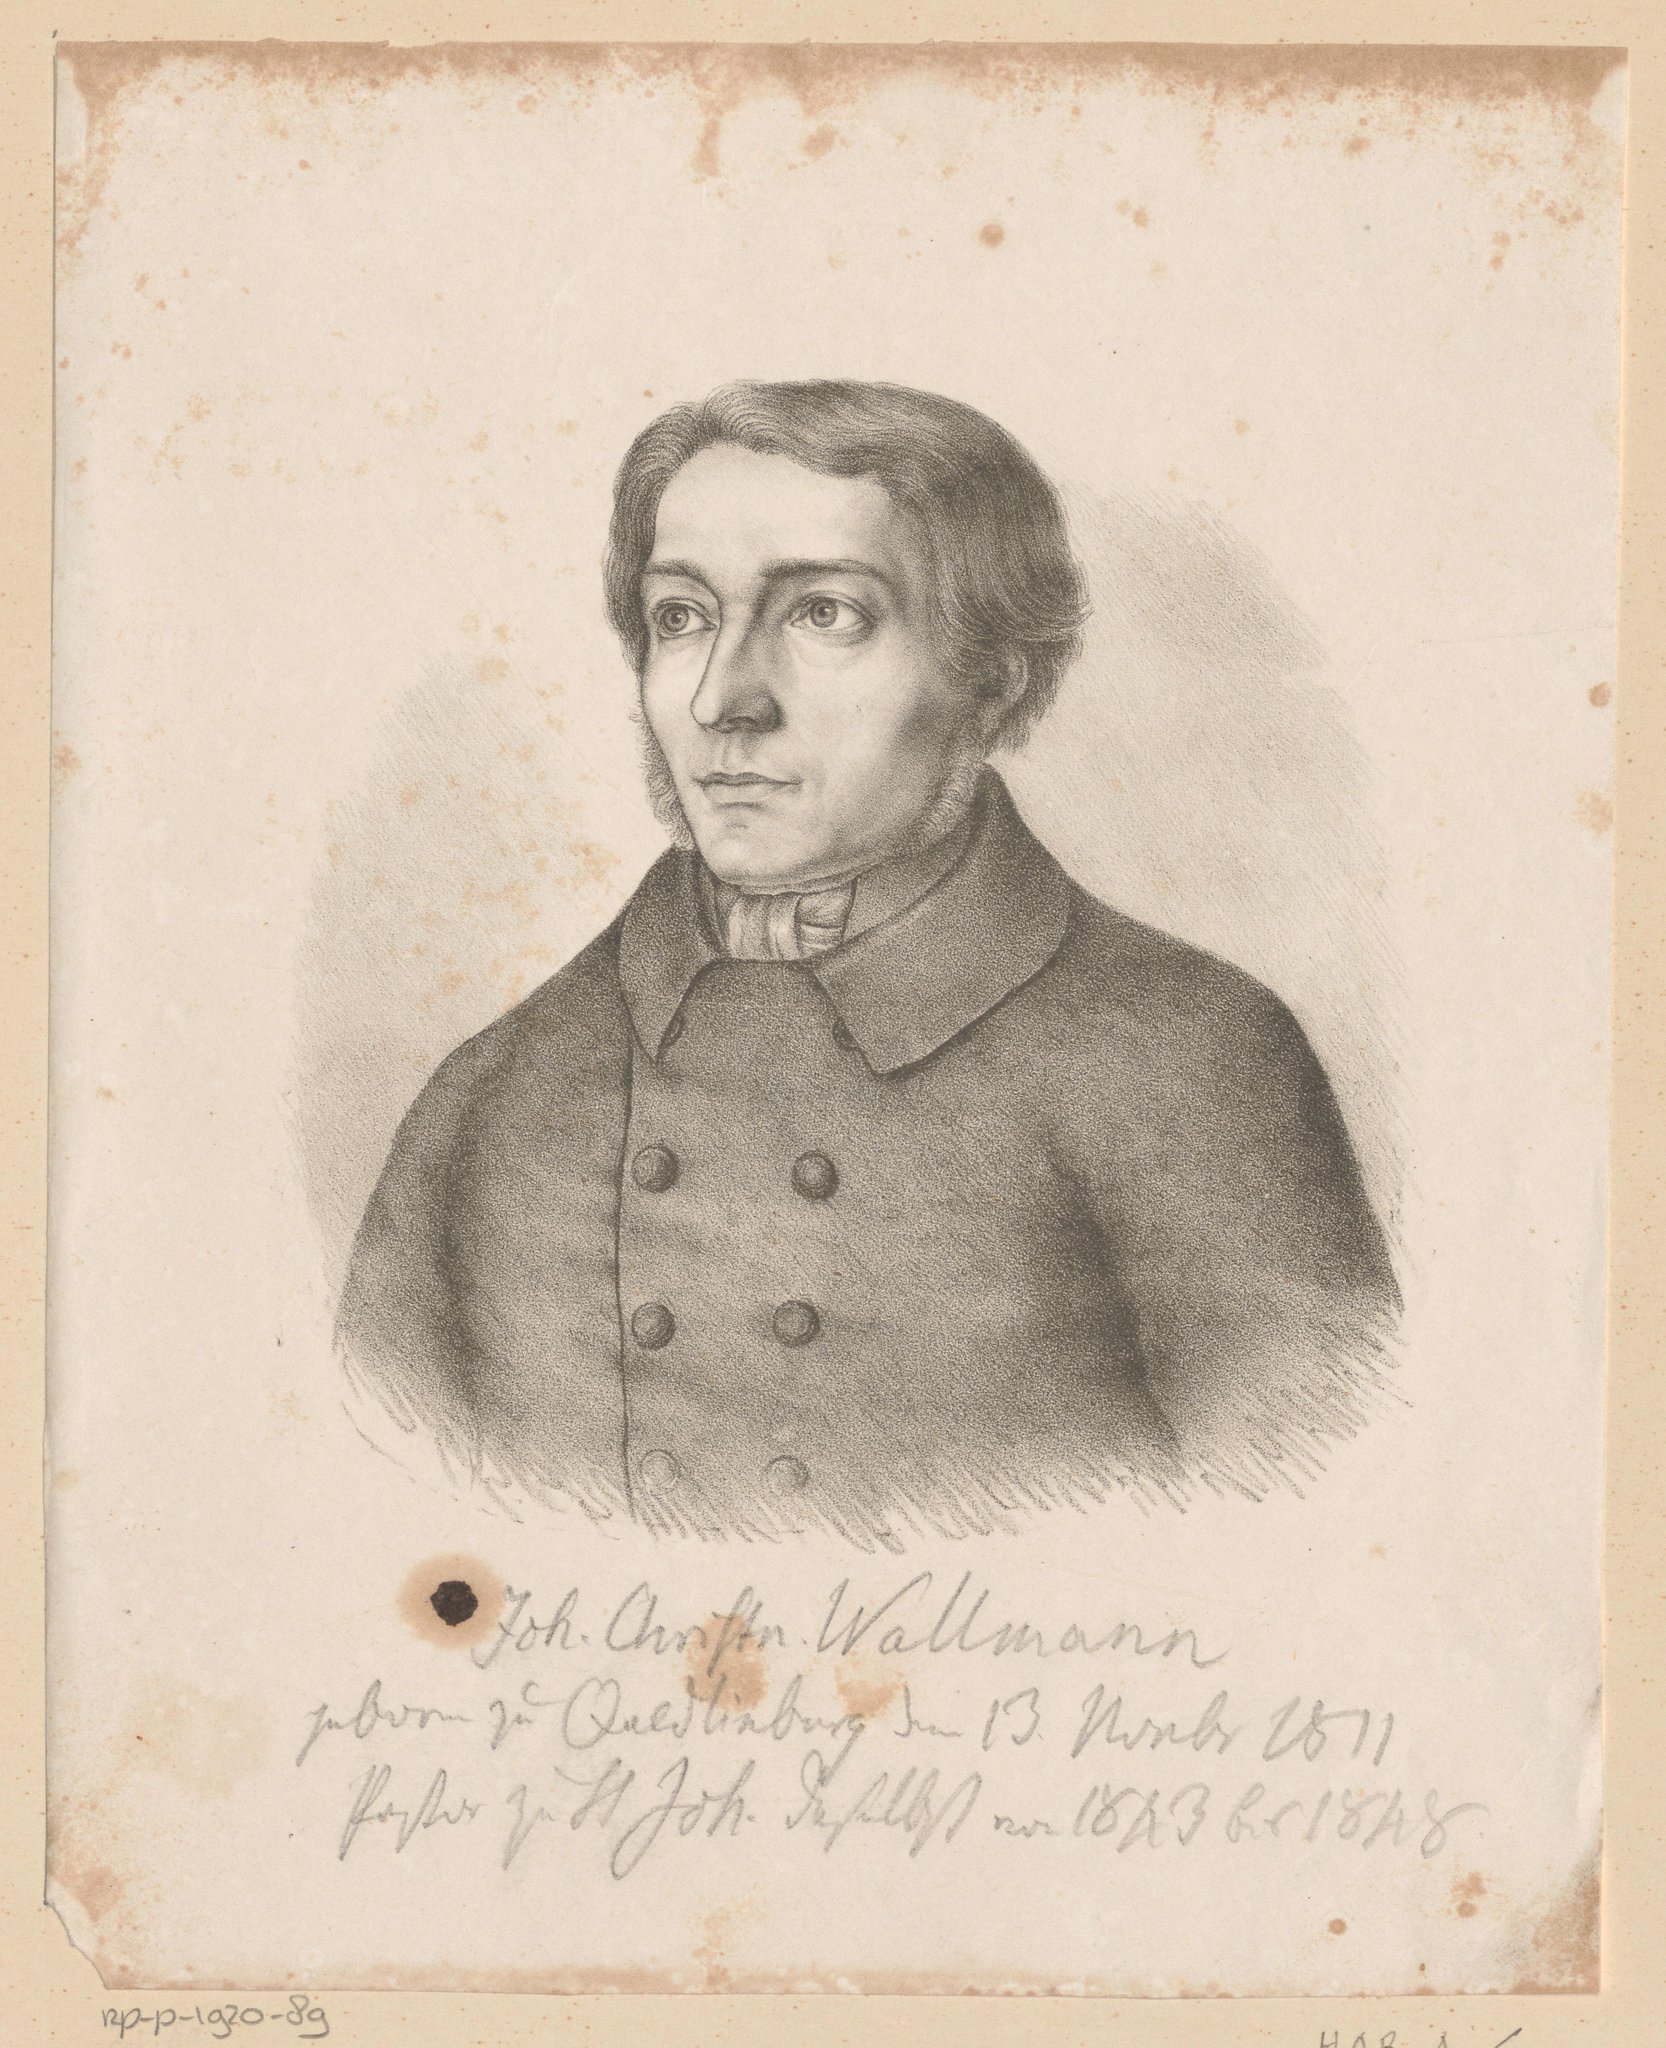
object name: print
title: Portret van Johann Christian Wallmann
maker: Anonymous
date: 1831-1899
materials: paper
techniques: lithograph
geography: germany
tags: theologian, historical persons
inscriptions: collector's mark: Lugt 2228, inscription: ‘Joh. Christn. Wallmann, geboren zu Quedlinburg am 13 November 1811, Pastor zu St. joh. daselbst von 1843 bis 1848.’